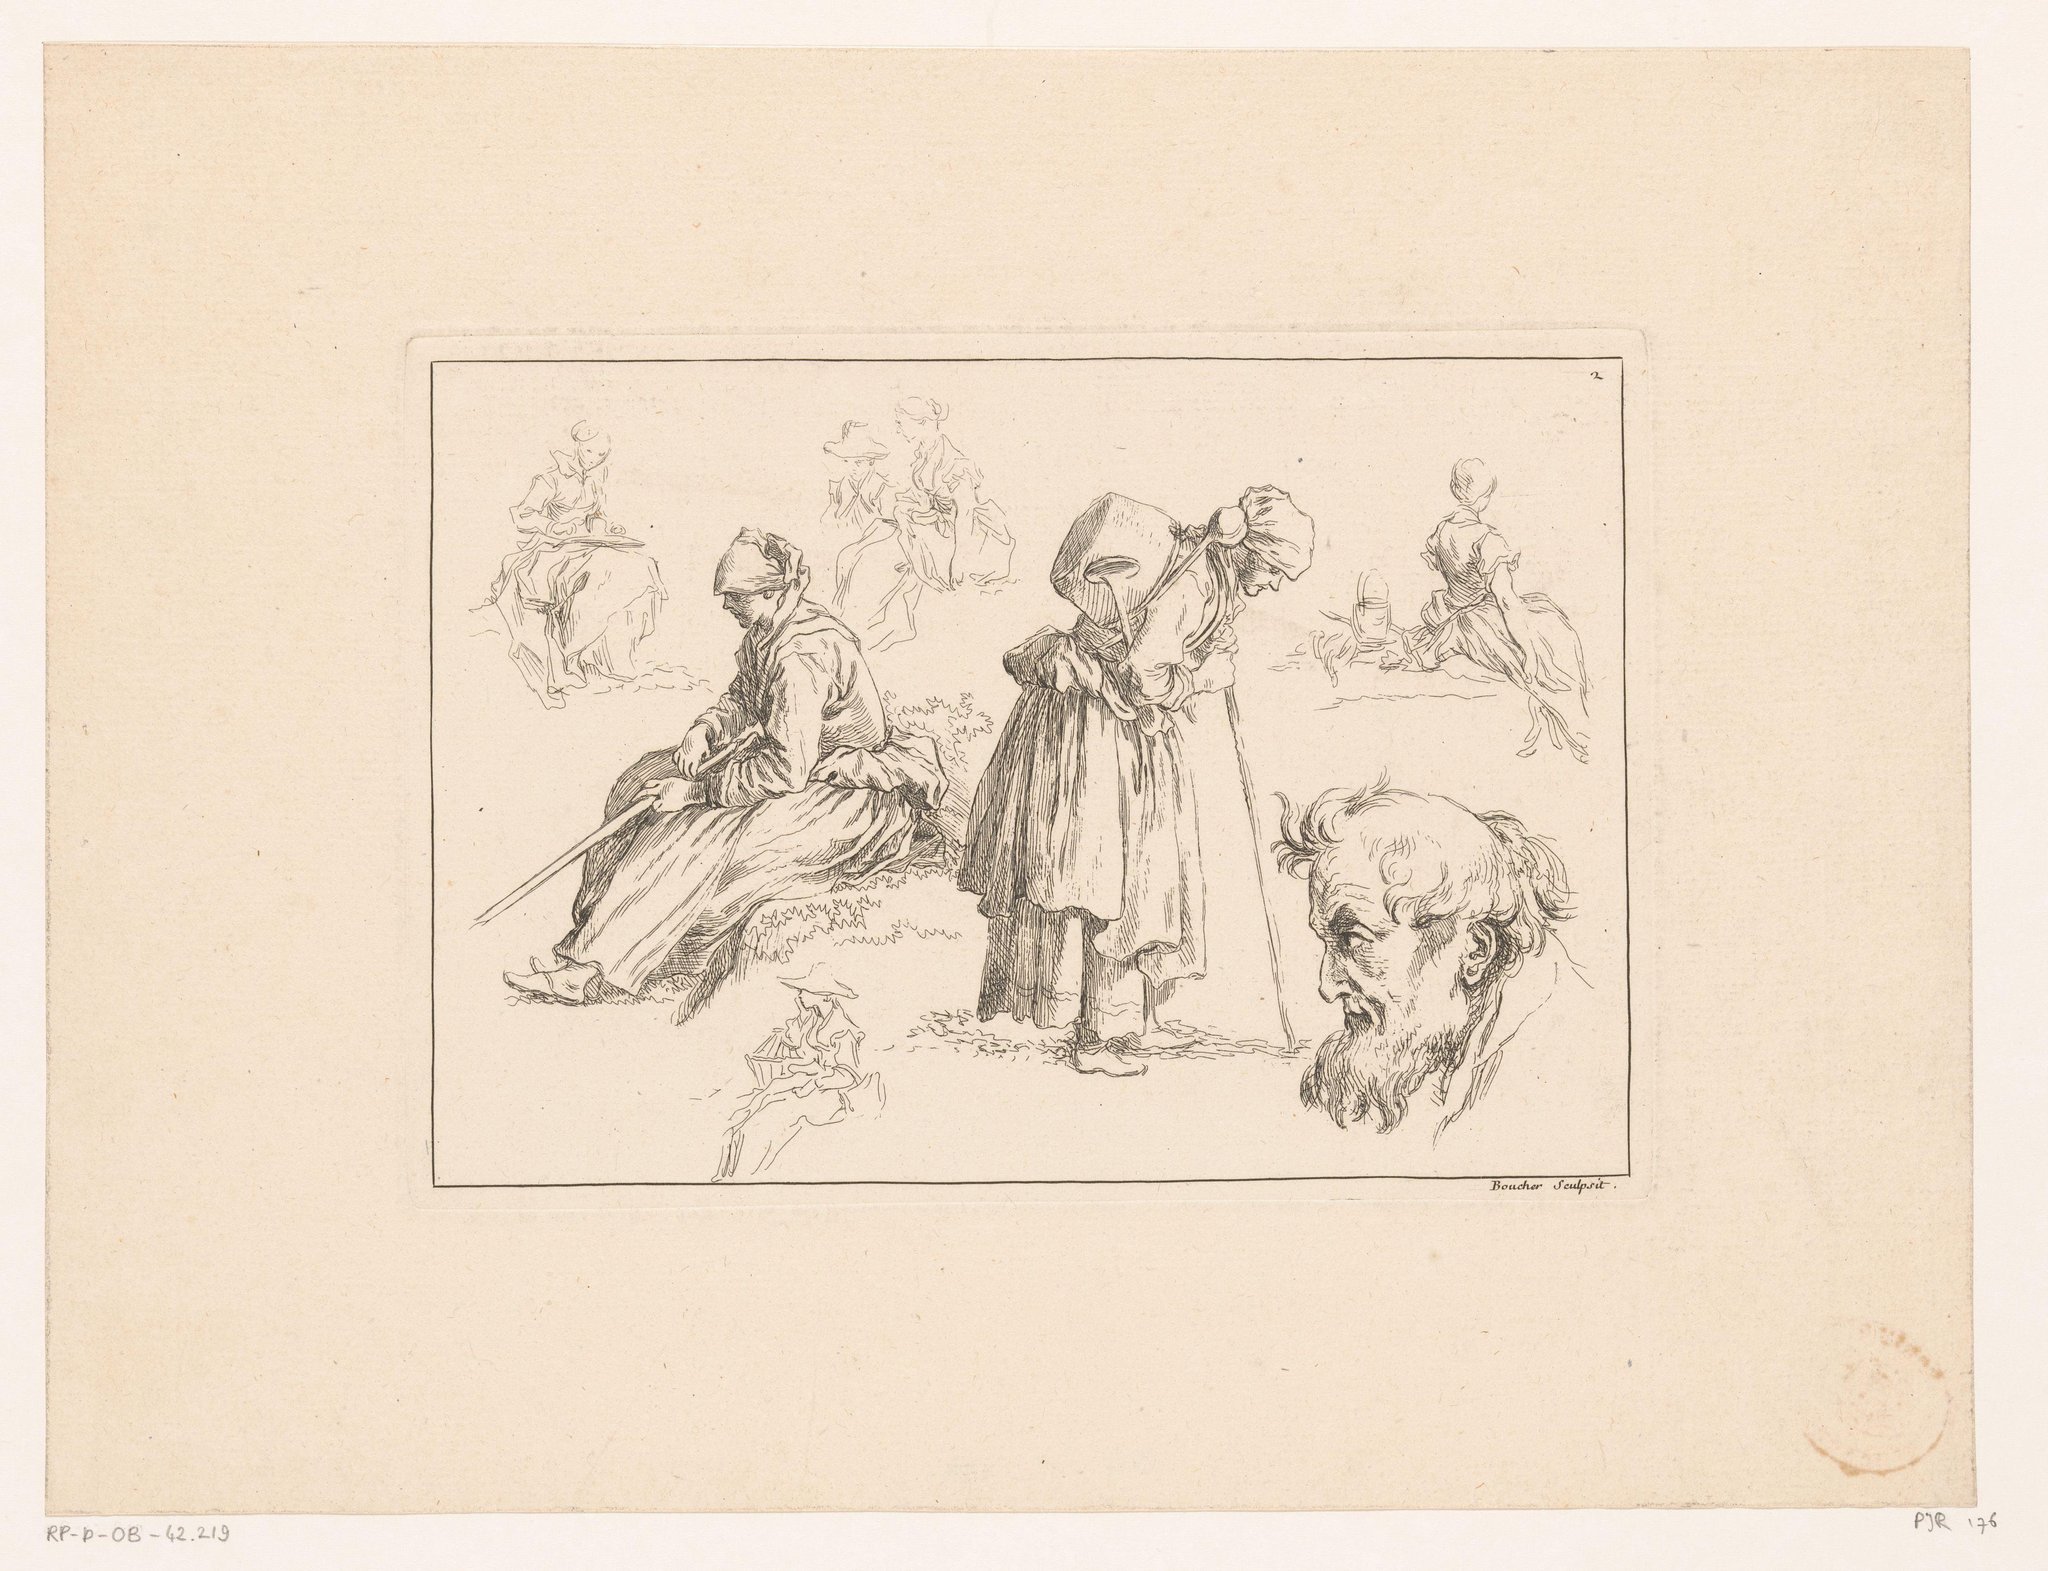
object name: print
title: Acht figuren met in het midden een oude vrouw met wandelstok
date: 1735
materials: paper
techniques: etching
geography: france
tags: sitting figure, walking-stick, staff, old man, old woman, standing figure - aa - female human figure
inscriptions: collector's mark: Lugt 240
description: Maakt deel uit van een serie van twaalf prenten naar tekeningen door Abraham Bloemaert, getiteld 'Livre d'Etude d'après les Desseins Originaux de Blomart'.